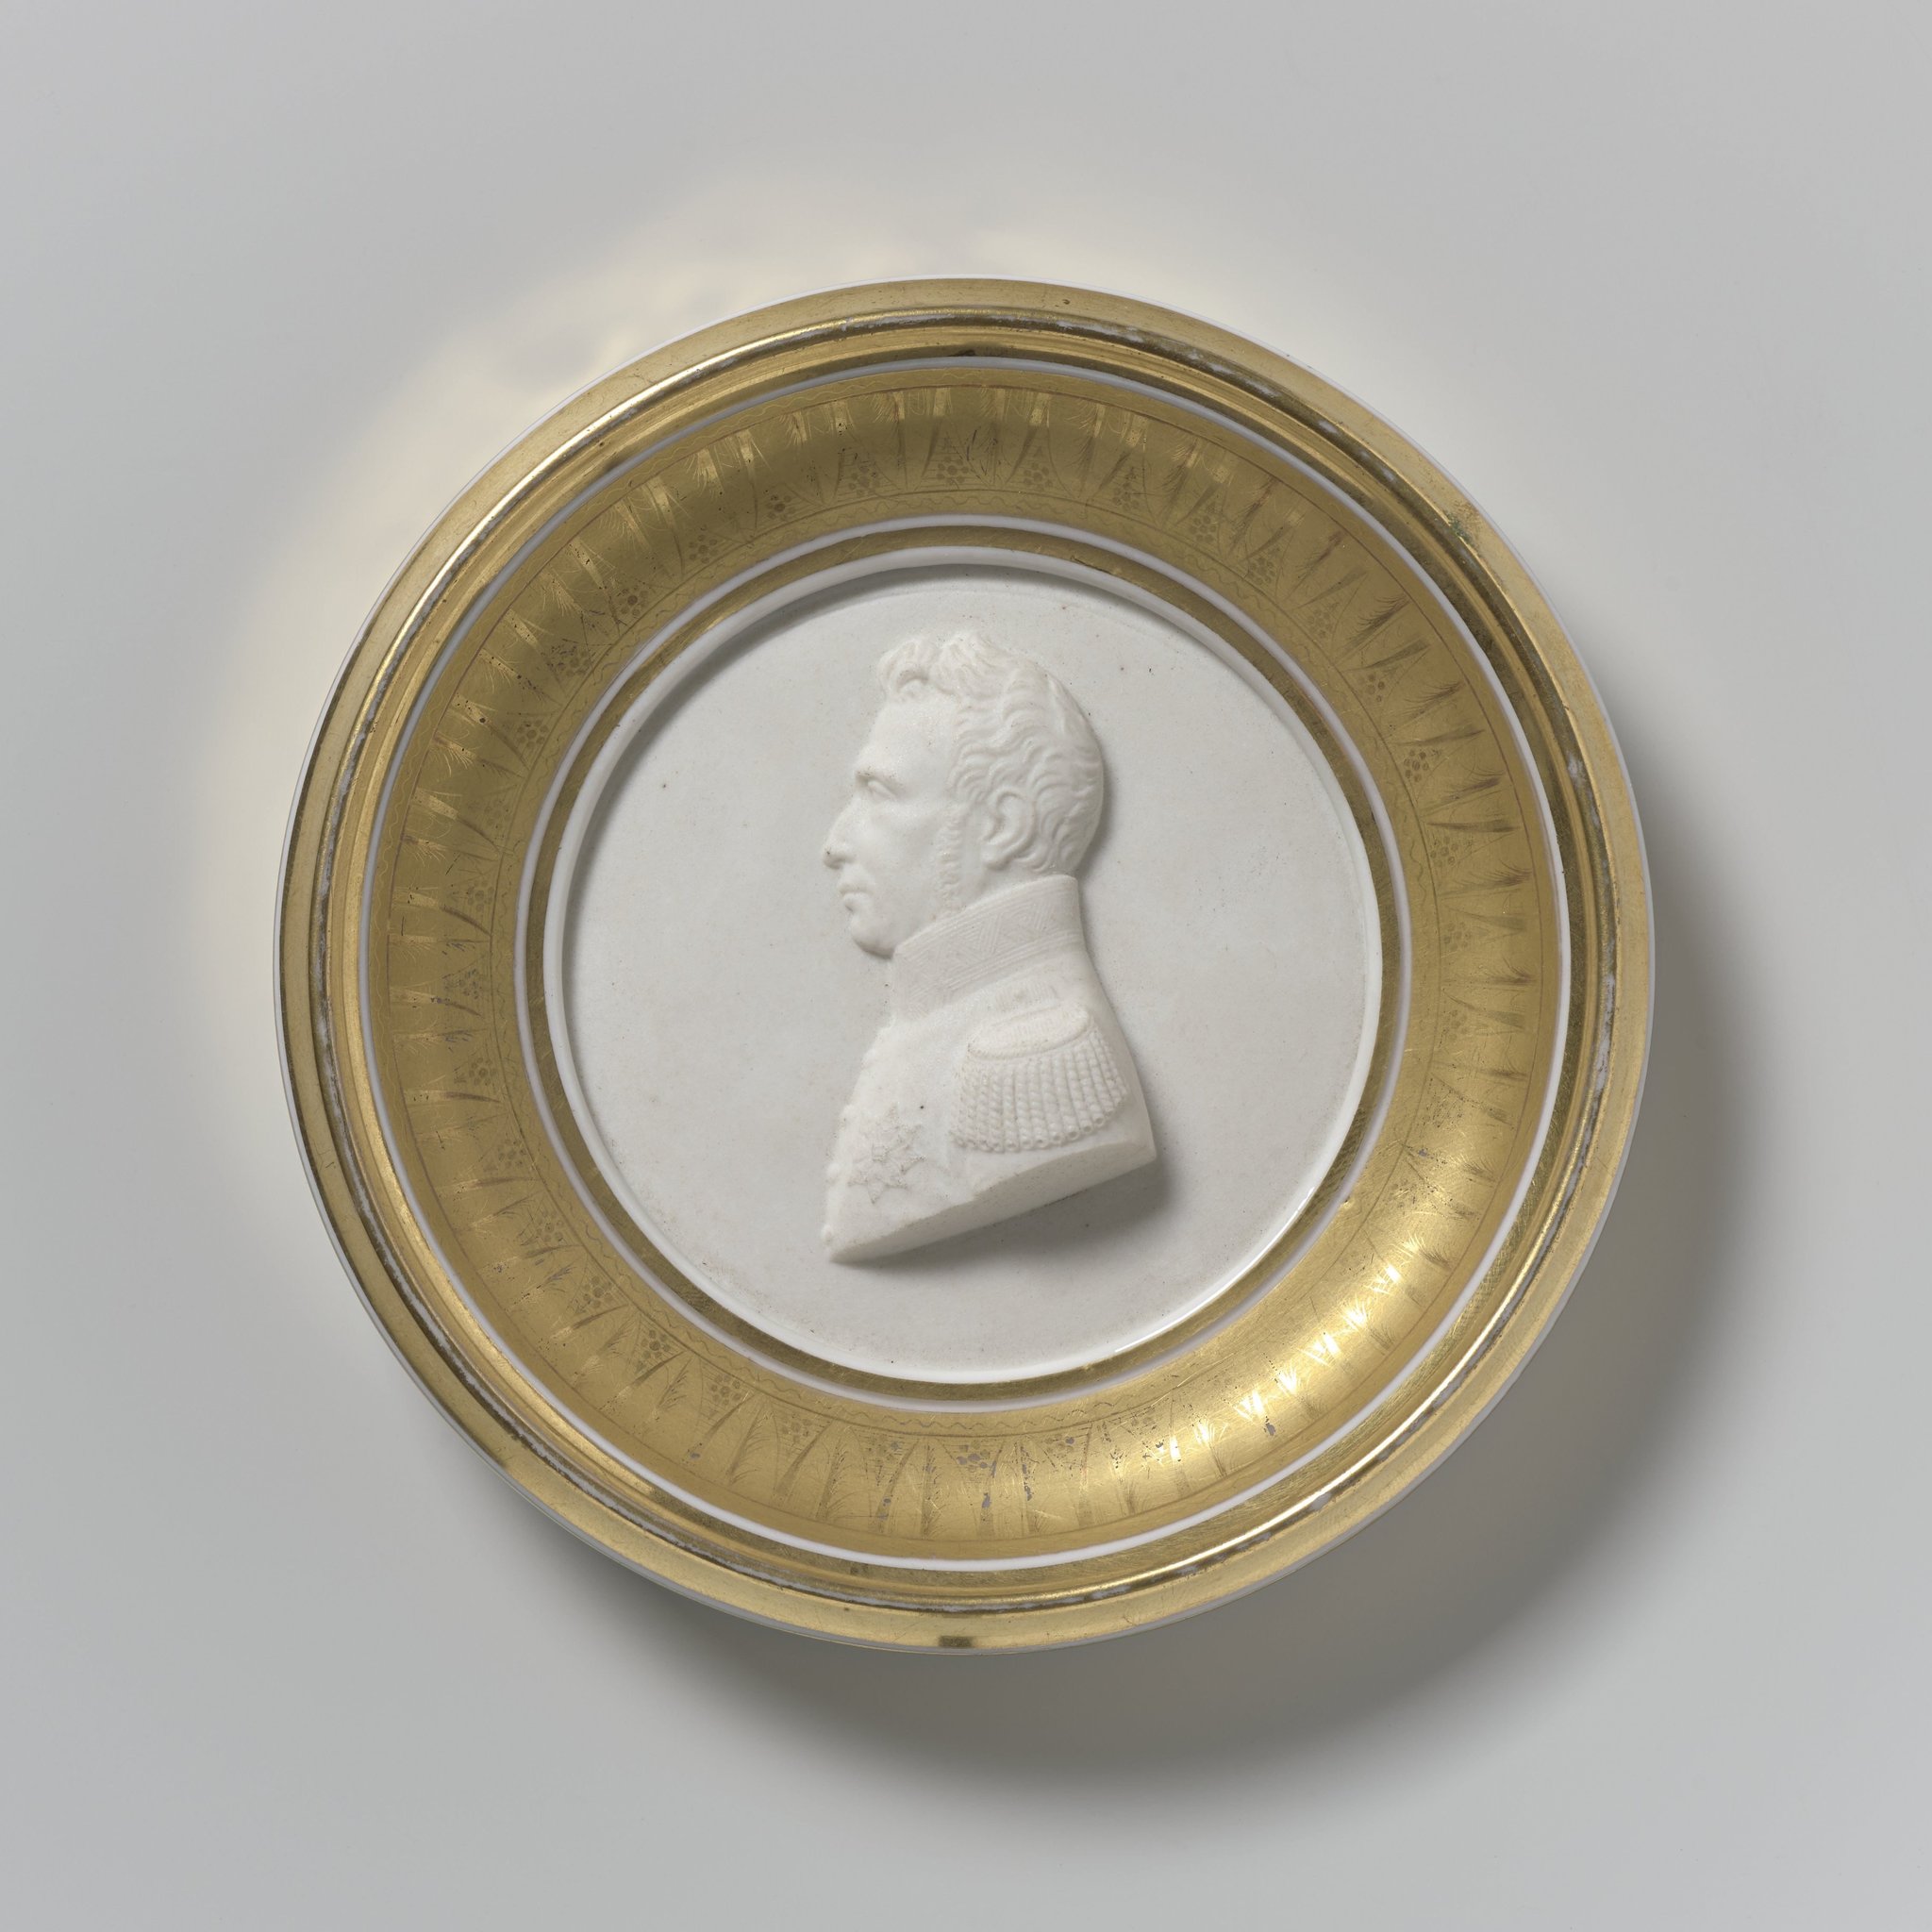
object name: locket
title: Medallion with the portrait of William I, king of the Netherlands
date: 1825-1849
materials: glaze, gold, paint, porcelain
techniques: firing, forming, gilding, vitrification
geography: doornik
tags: the hague, berlin, william i of the netherlands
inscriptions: signature: ‘BRICHAUT F’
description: Medaillon van porselein, beschilderd op het glazuur in goud. Het medaillon toont in biscuit en profil het portret van Willem I, koning der Nederlanden in reliëf. Het portret is gesigneerd met BRICHAUT F. Om het medaillon een ronde lijst versierd met goud. Aan de binnenzijde is in het goud een band met rozetten en bladmotieven gegrift.